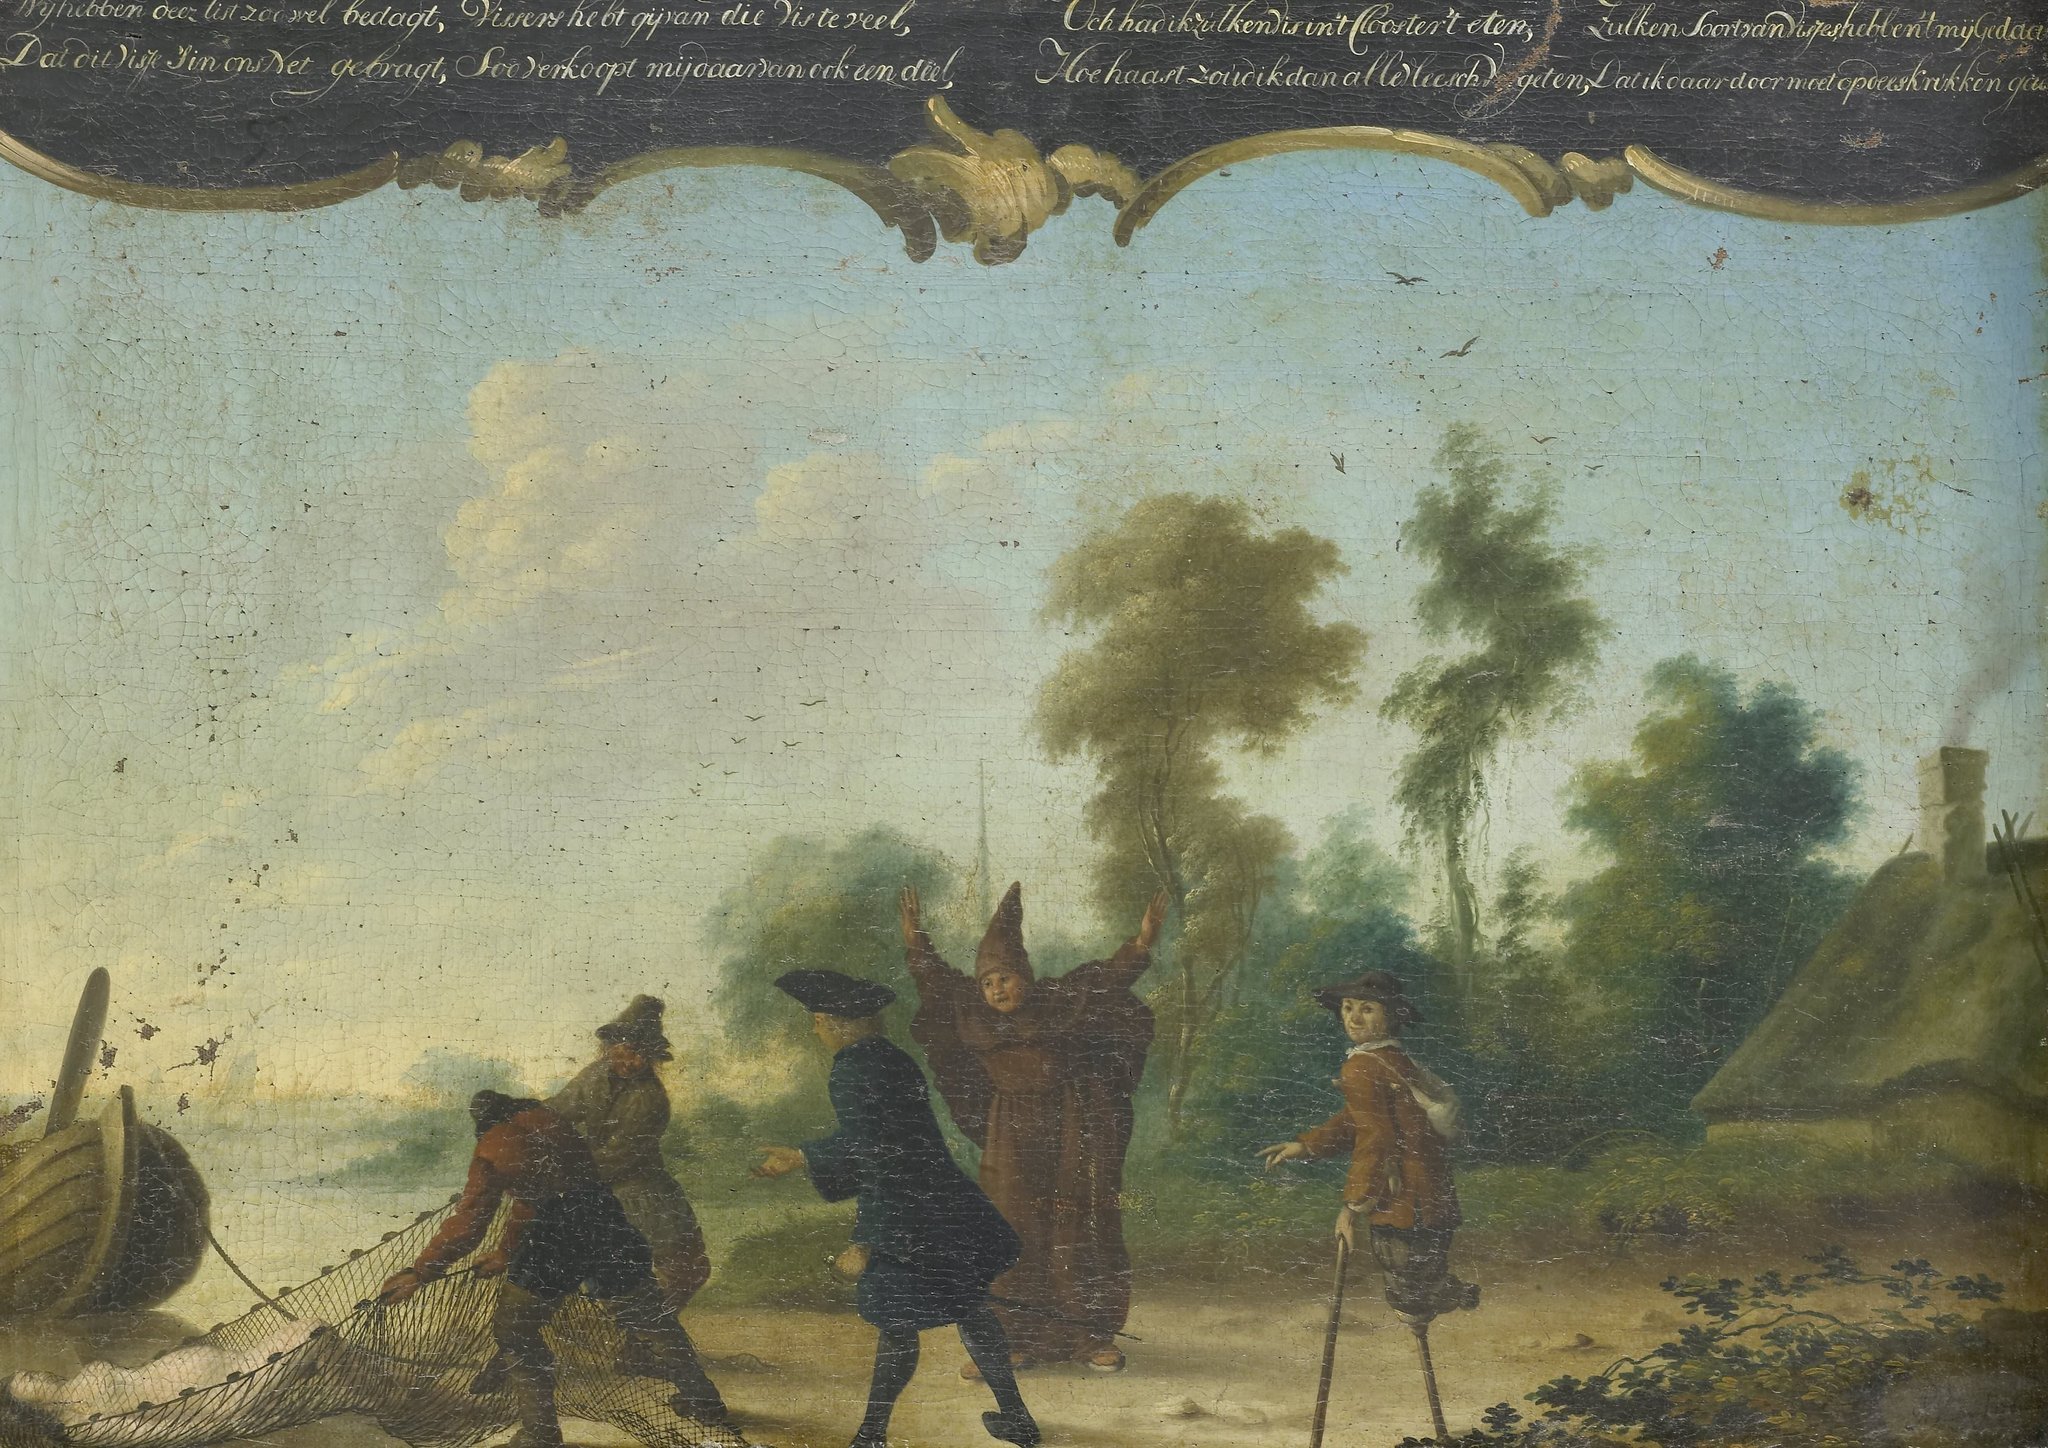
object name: painting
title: Allegory of Free Love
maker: joseph pierre vianey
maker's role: painter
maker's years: 1731-1765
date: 1761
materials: canvas, oil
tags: fishing net, relations between the sexes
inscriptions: inscription: ‘Wij hebben deez list zoo wel bedagt / Dat dit visje 's in ons net gebragt // Vissers hebt gij van die vis te veel / Soo verkoopt mij daarvan ook een deel // Och had ik zulken vis in't clooster 't eten / Hoe haast zoud ik dan alle vleesch vergeten // Zulken soort van visjes hebben 't mij gedaan / Dat ik daarvoor moet op dees krukken gaan.’, signature and date: ‘P. Vianey f. 1761’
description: Allegorie op de vrije liefde: een heer, een monnik en een bedelaar sprekend met twee vissers die een naakte vrouw in een net gevangen hebben.